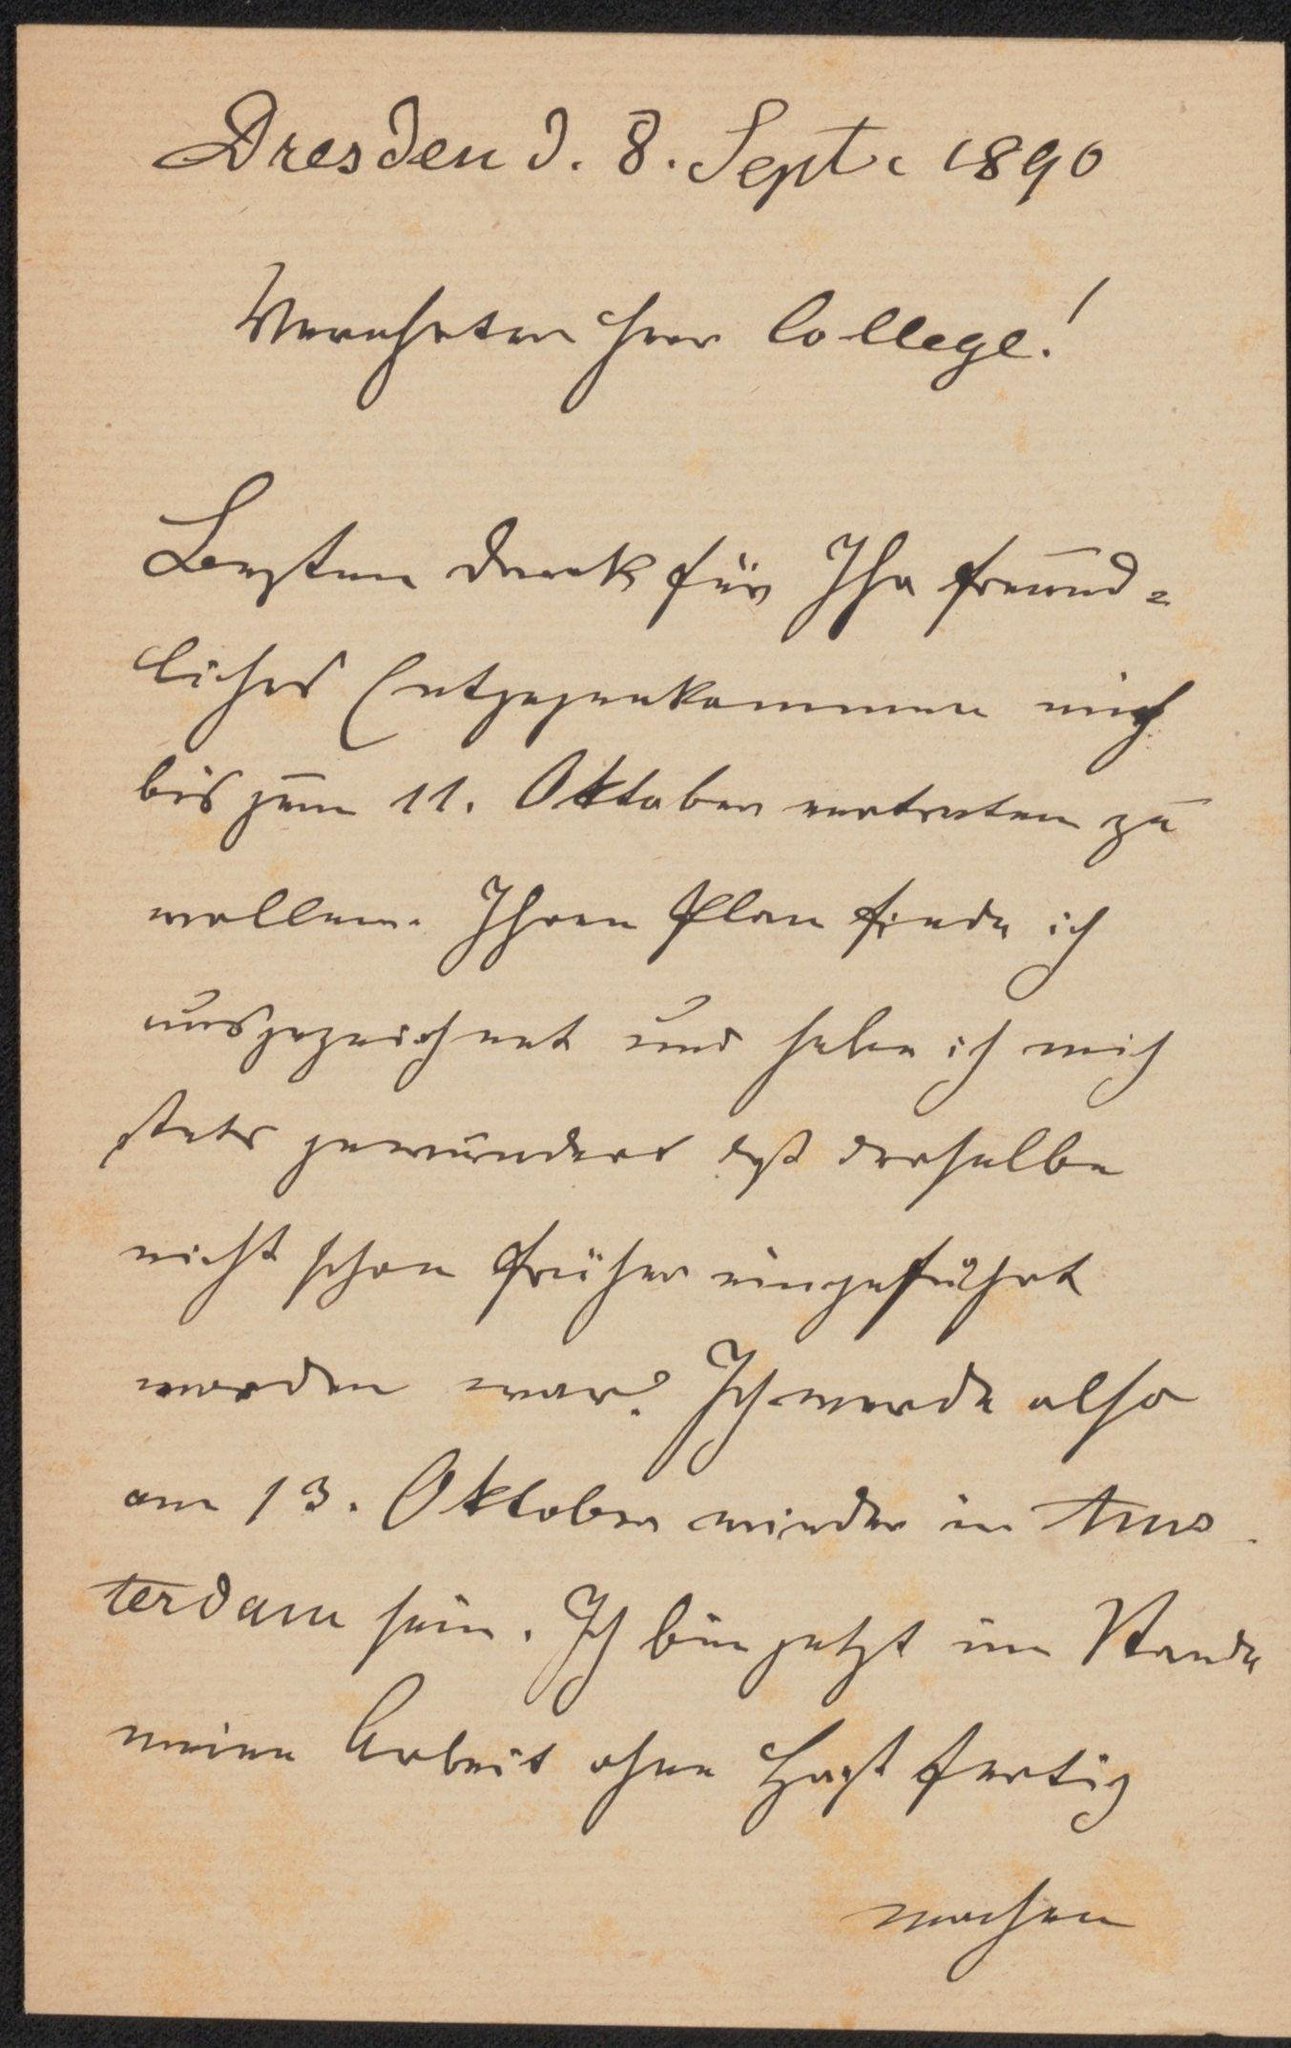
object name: letter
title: Brief aan August Allebé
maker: rudolf stang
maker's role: draughtsman, painter, print maker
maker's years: 1831-1927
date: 1890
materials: ink, paper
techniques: pen, writing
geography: dresden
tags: august allebé, amsterdam